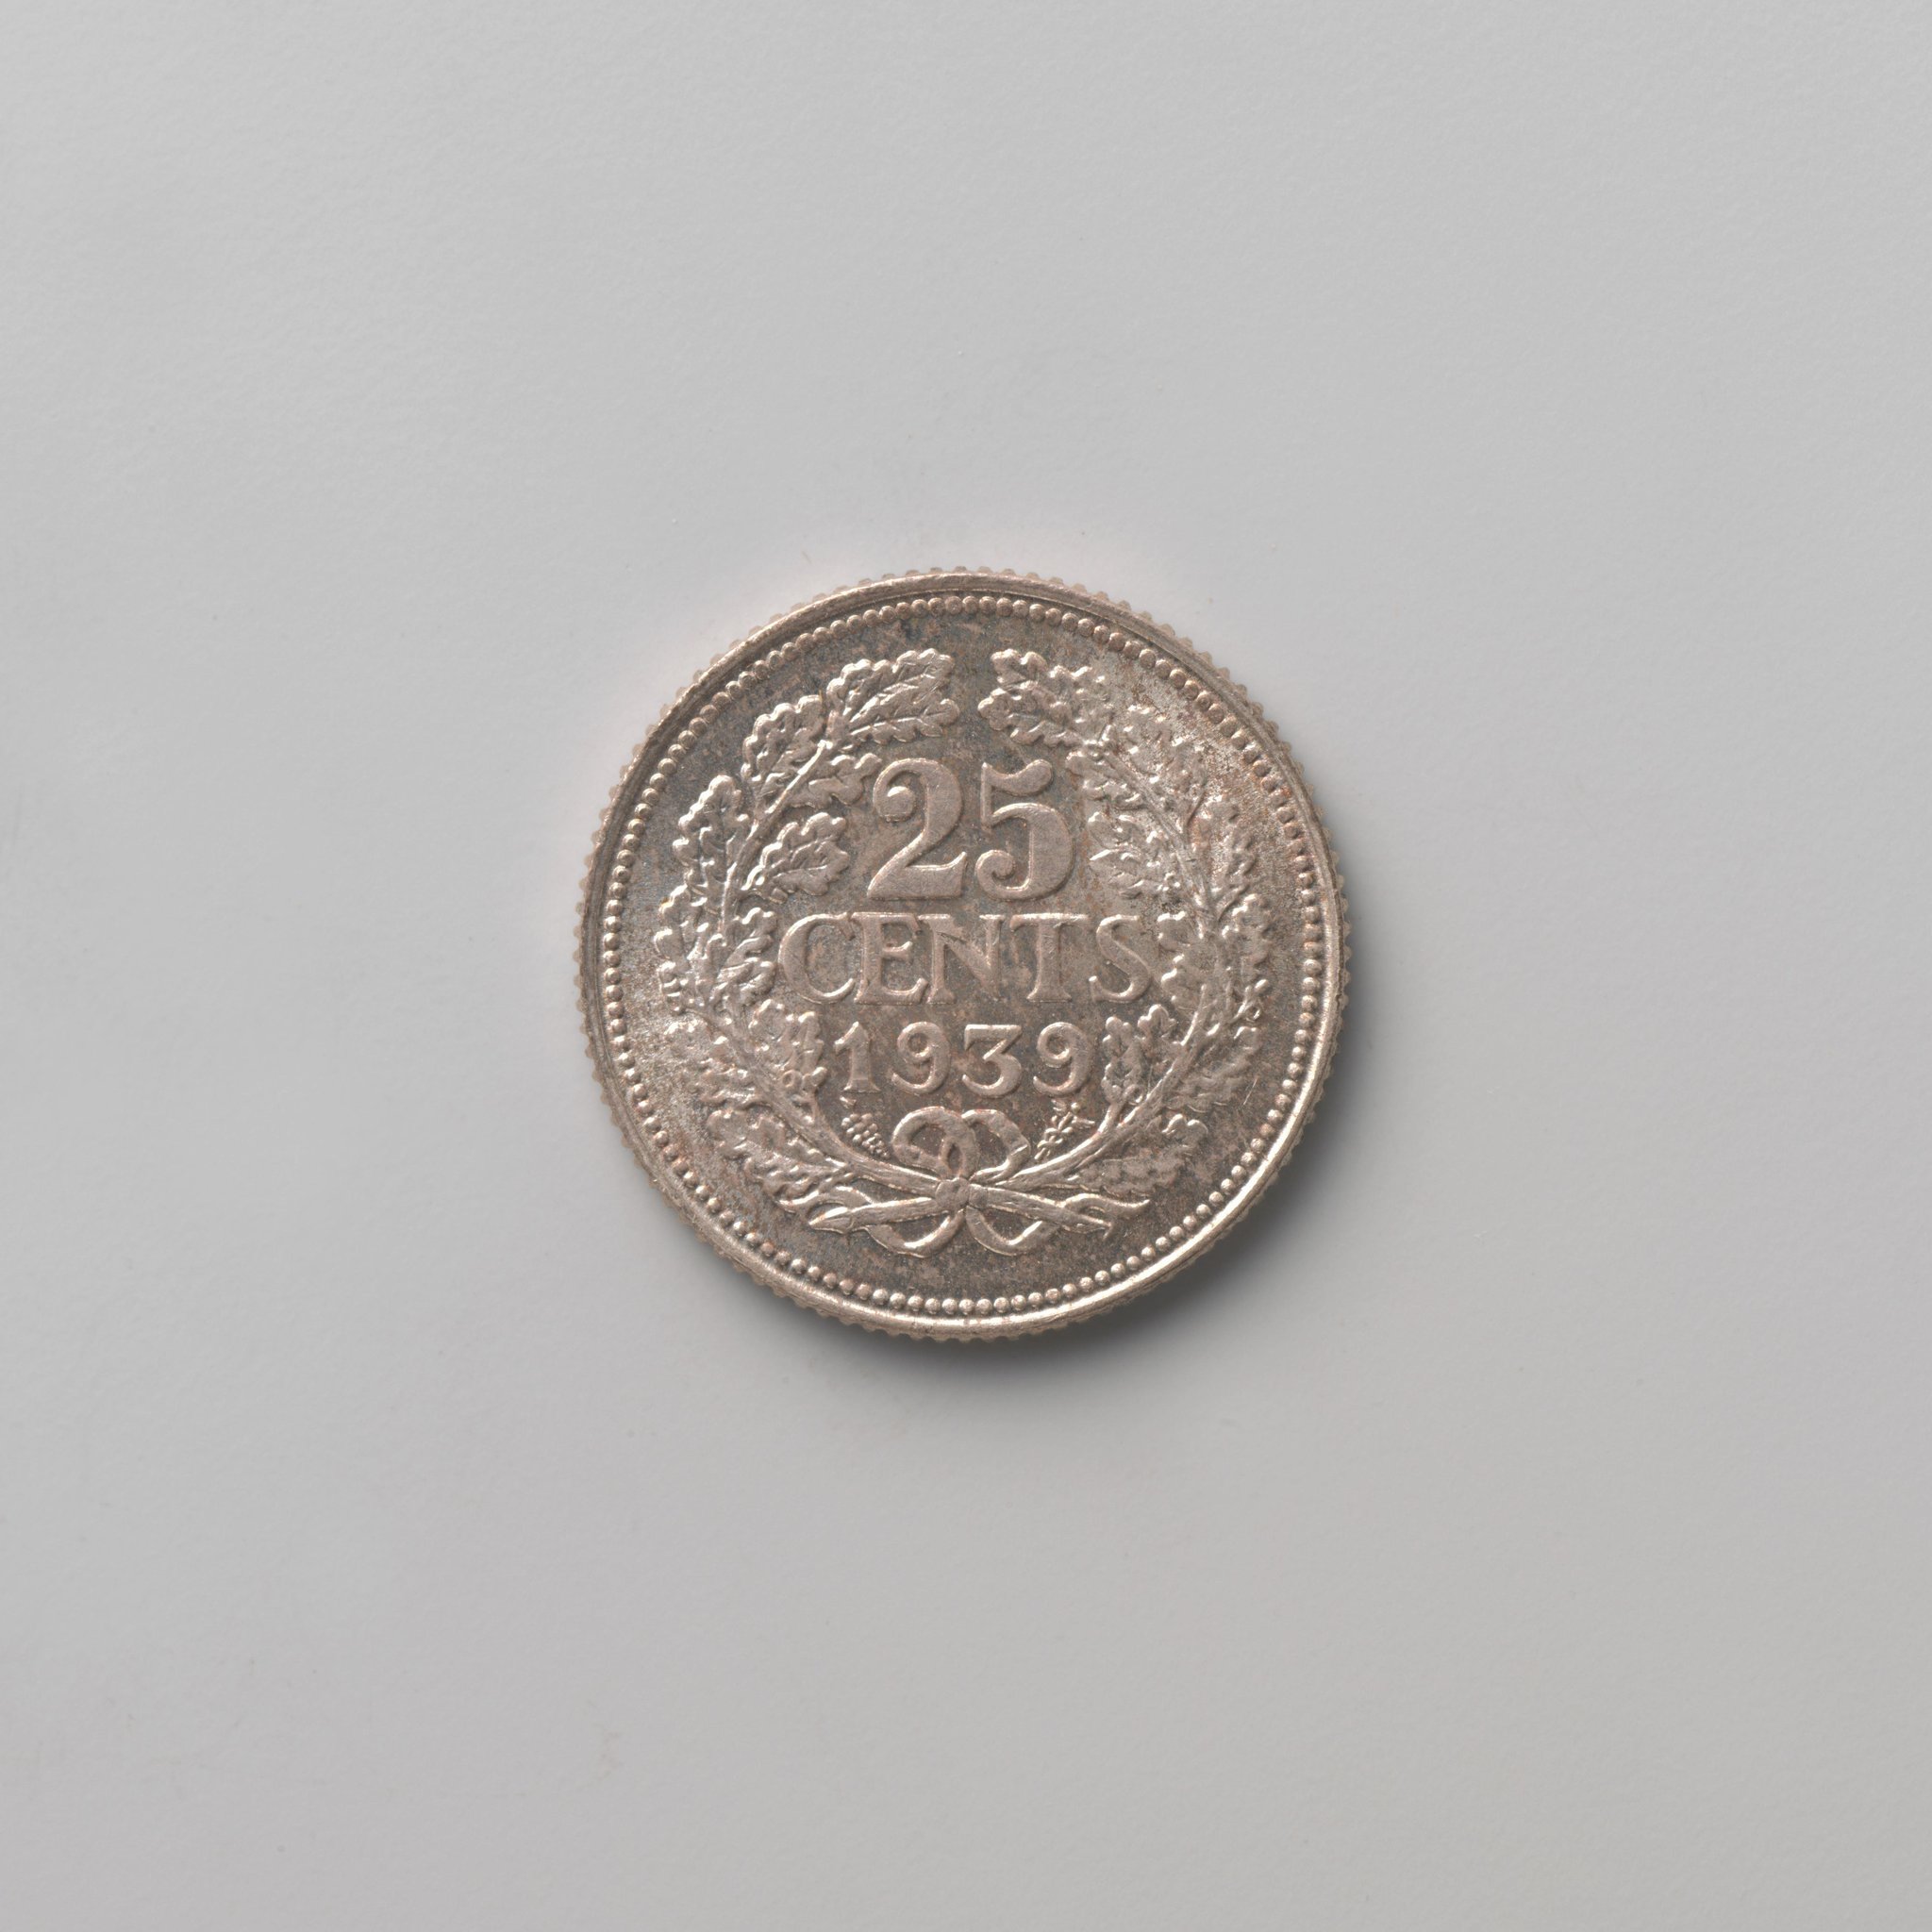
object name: coin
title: Nederland, 25 cent,1939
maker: wilhelmina of the netherlands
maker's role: print maker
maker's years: 1880-1962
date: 1939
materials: silver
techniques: striking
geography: utrecht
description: Zilveren munt. Voorzijde: hoofd naar links. Keerzijde: binnen twee samengebonden eiketakken waarde-aanduiding 25 cents en jaartal. Kartelrand.